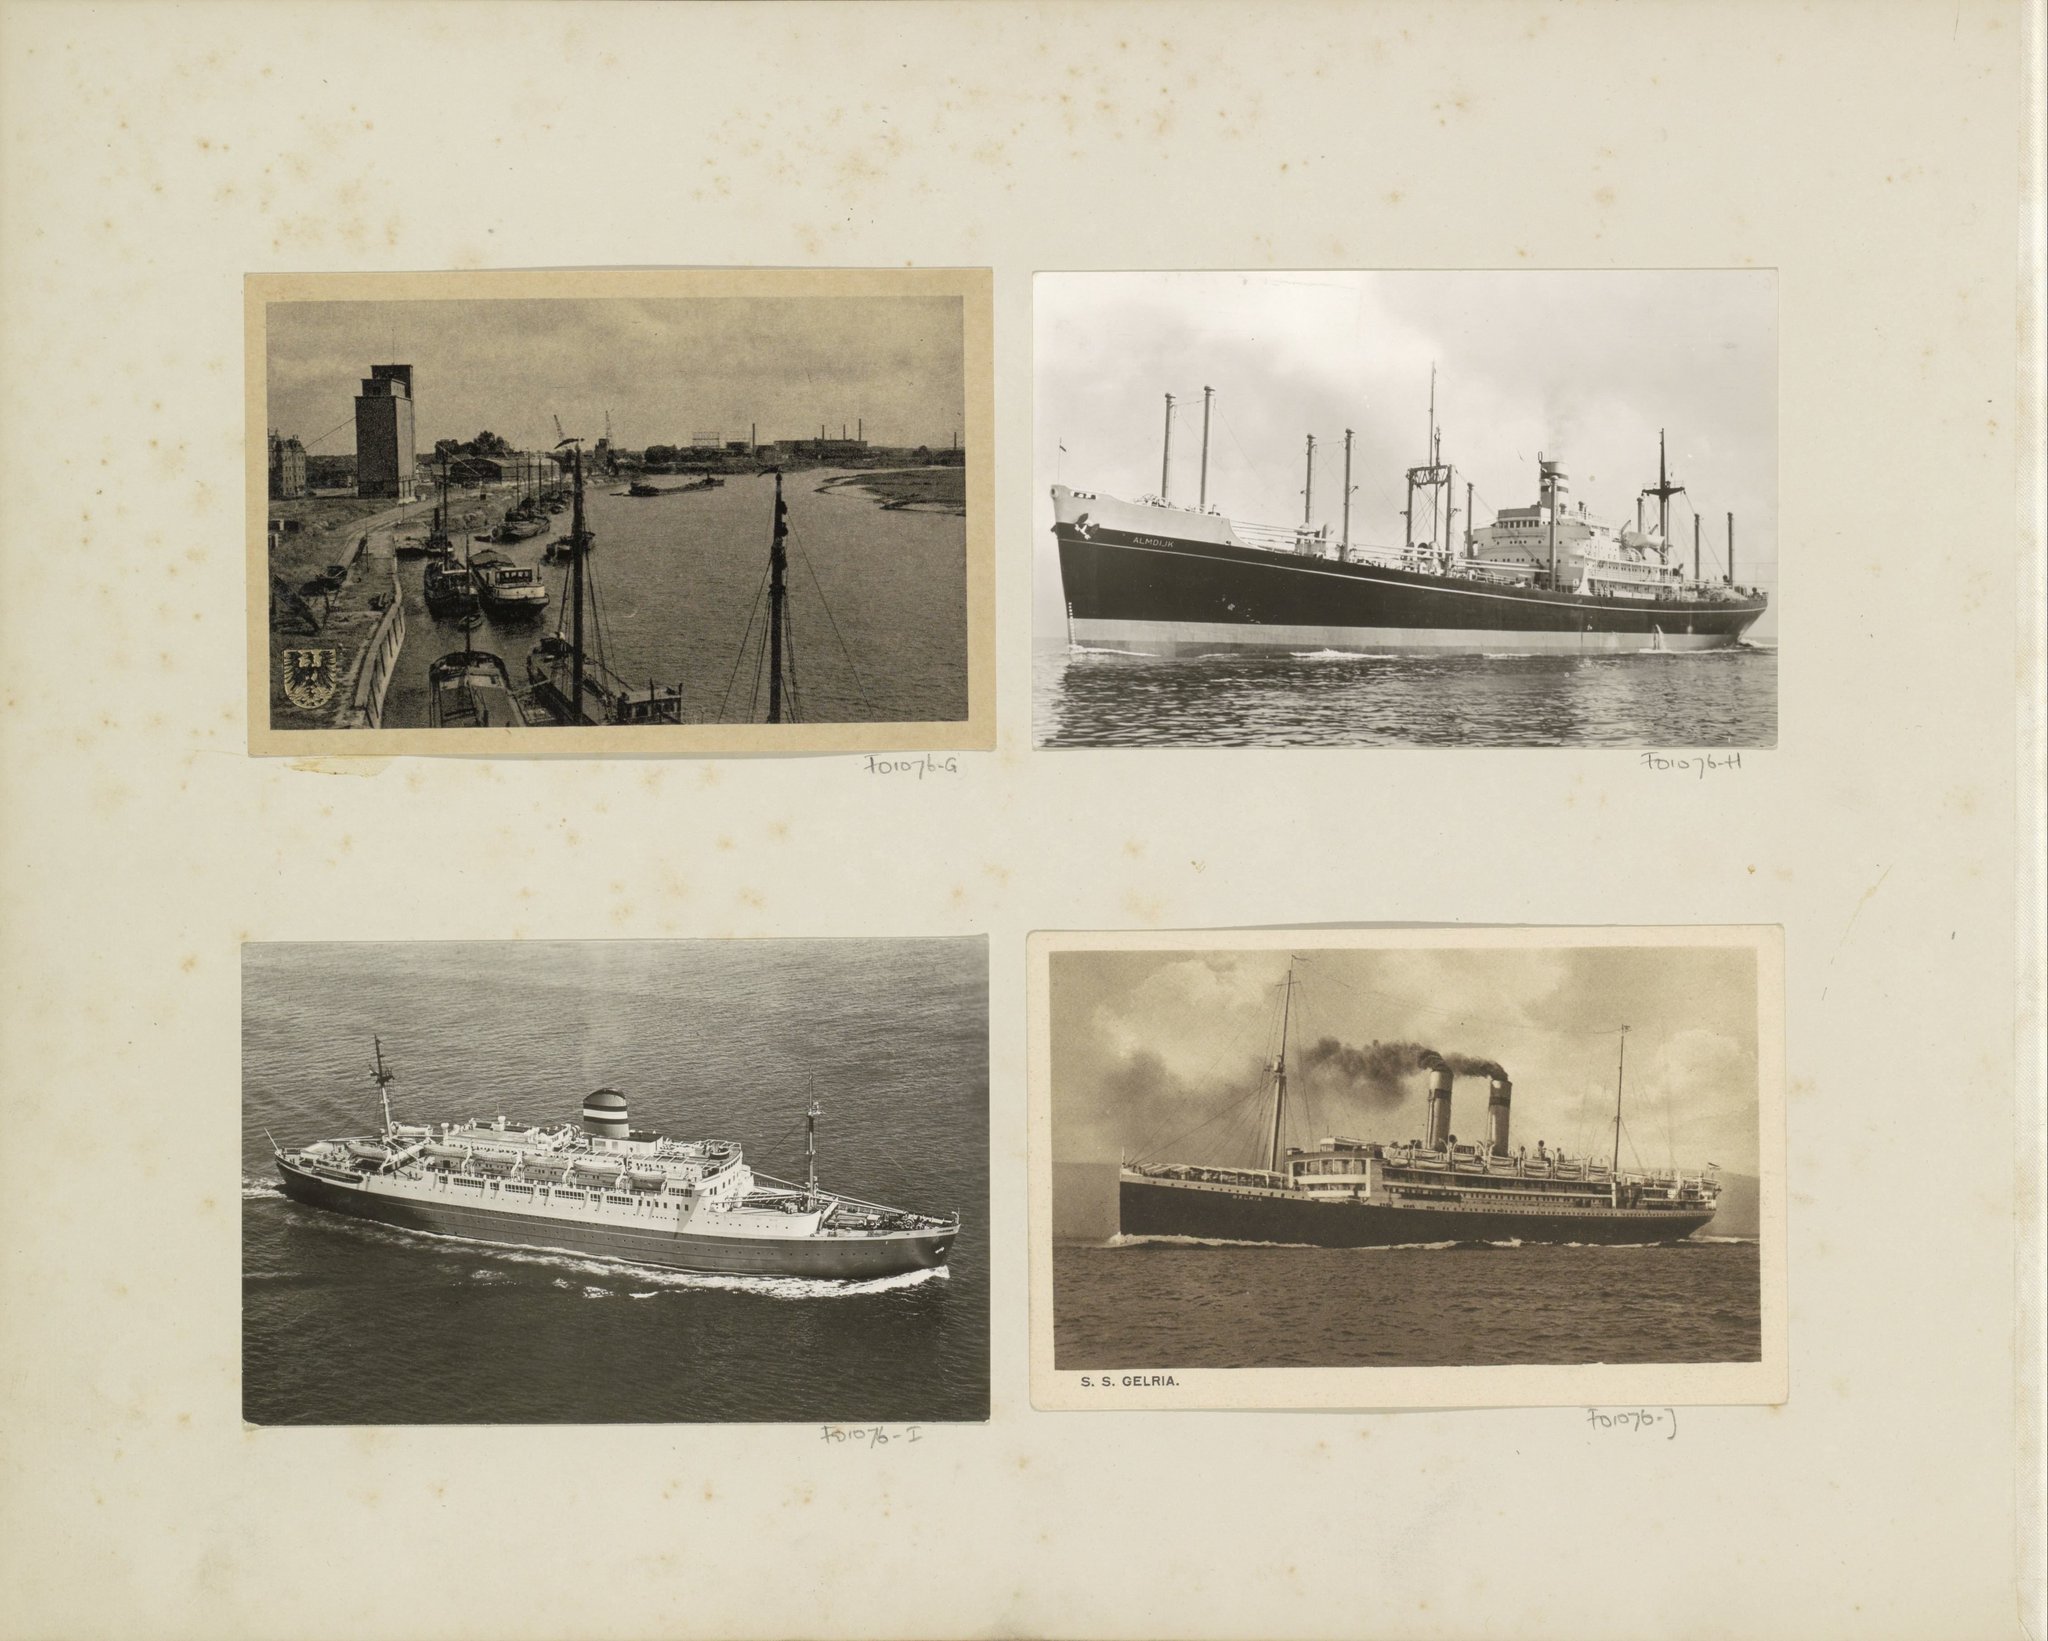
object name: ansichtkaart, prentbriefkaart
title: Schip 'Almdijk'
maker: Anonymous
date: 1900-1940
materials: cardboard, paper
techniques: gelatin silver print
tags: steamship, motorship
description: Onderdeel van Album met foto's van spoorwegen in Nederlands-Indië en prentbriefkaarten.